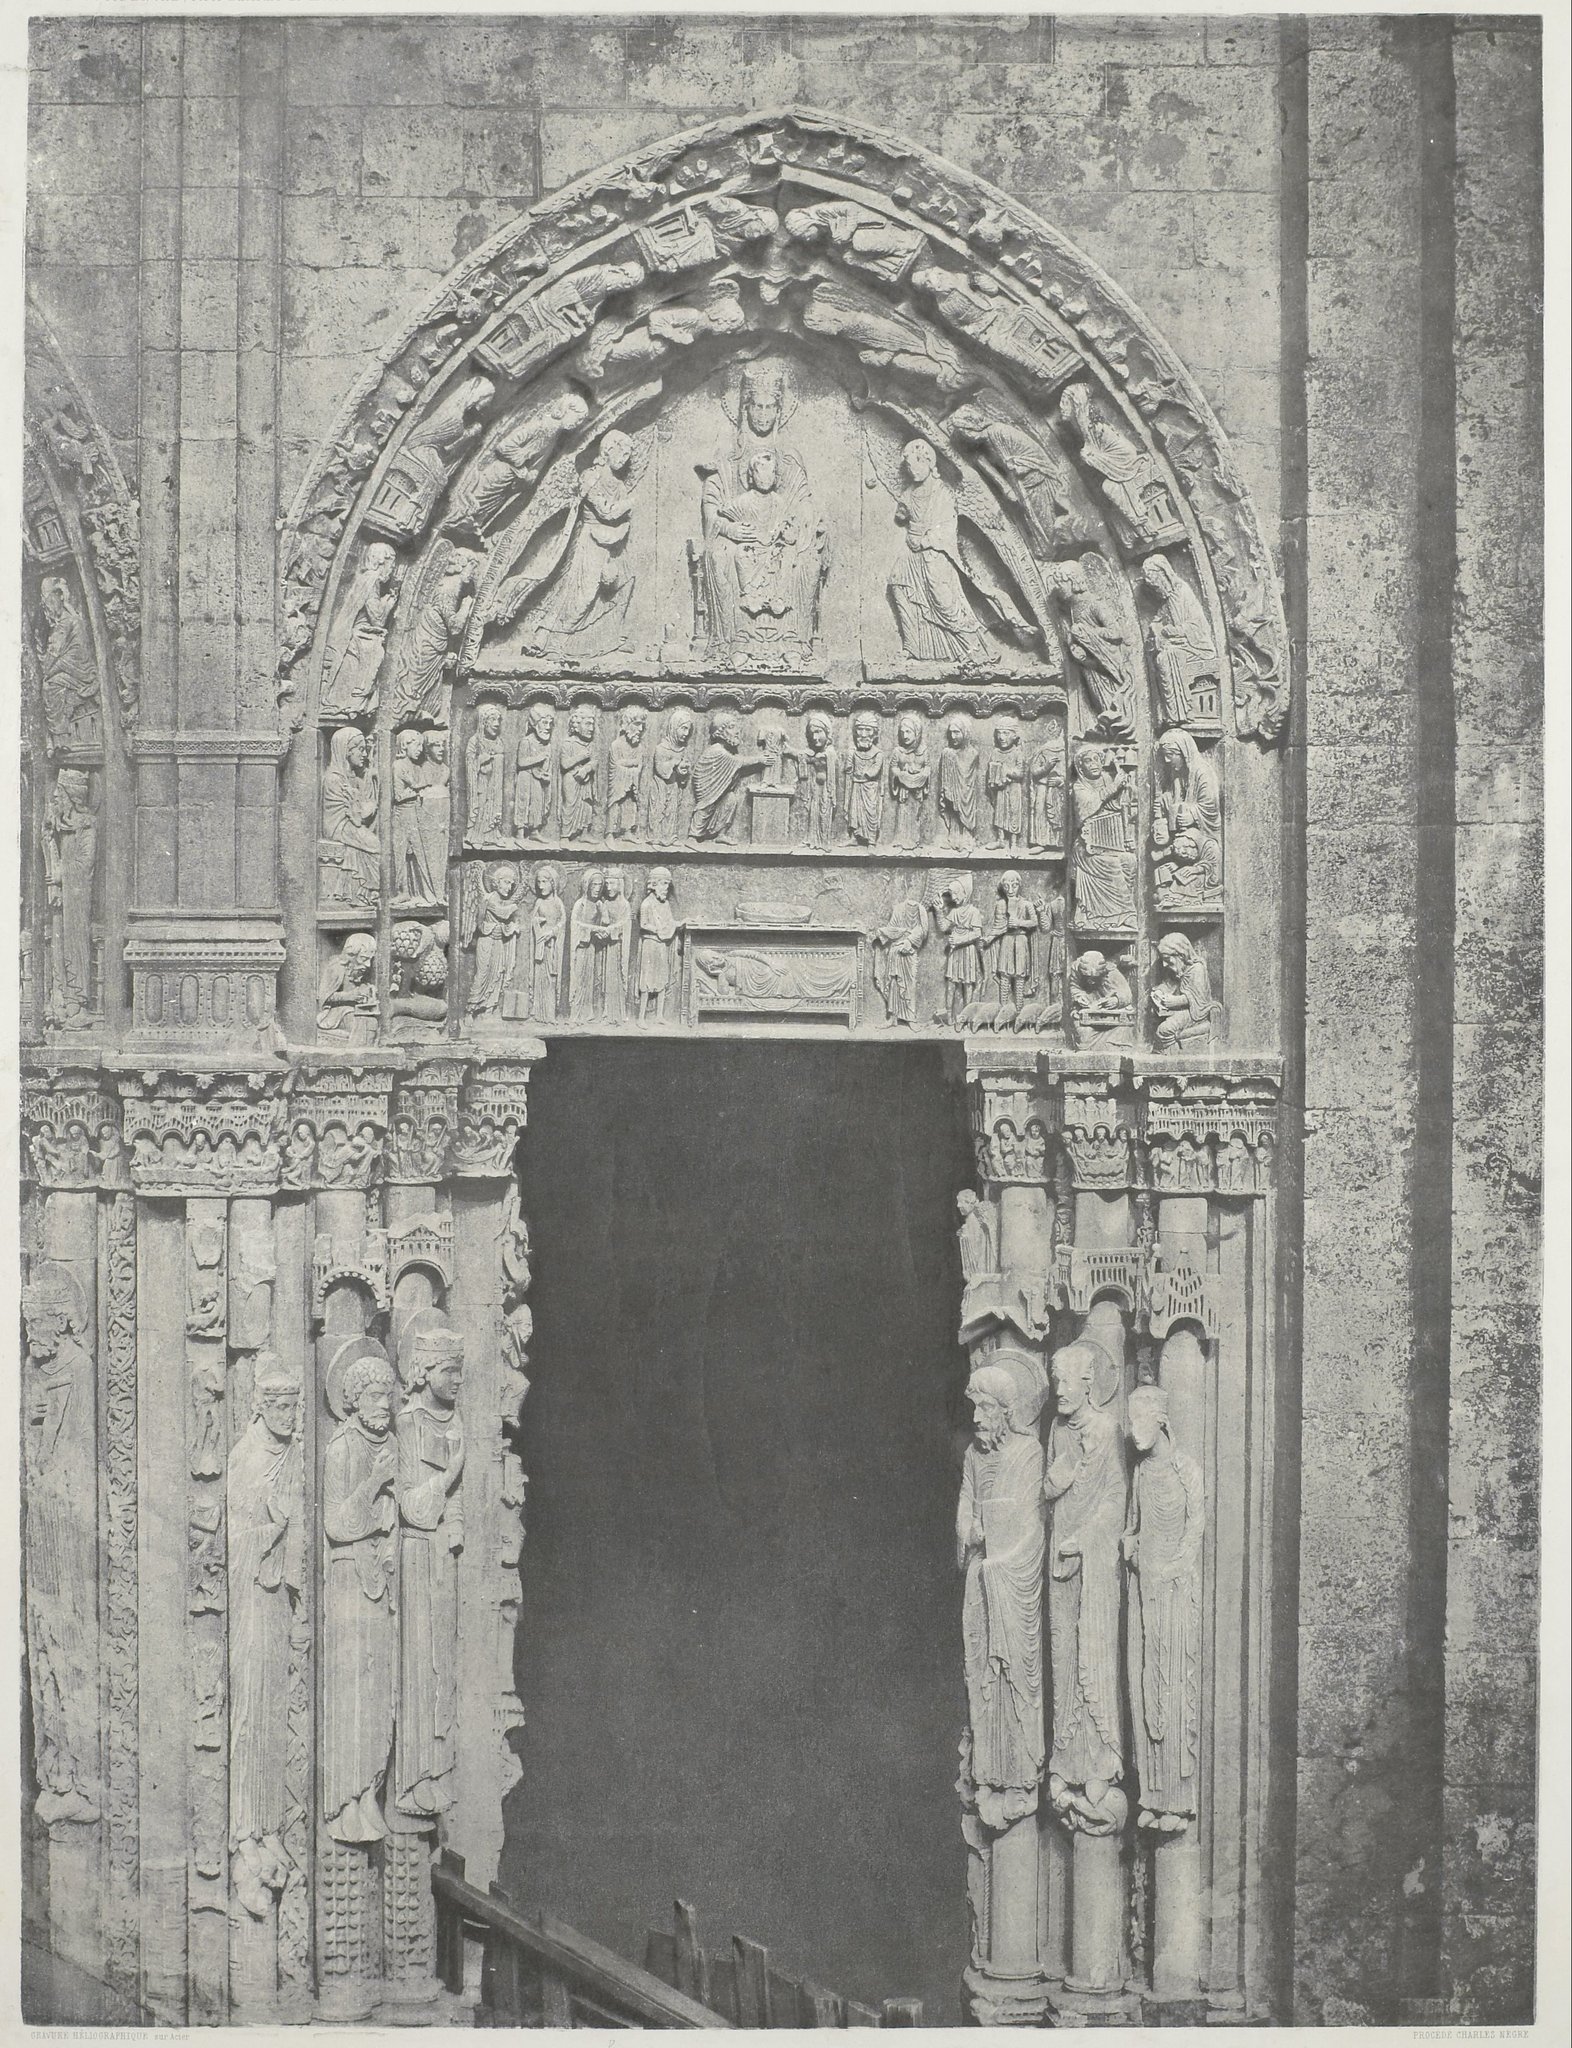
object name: photomechanical print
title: Côté Occidental, Porte Latérale de droite XII Siècle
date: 1854-1857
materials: cardboard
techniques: photoaquatint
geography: chartres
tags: parts of church exterior and annexes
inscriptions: inscription: ‘GRAVURE HÉLIOGRAPHIQUE sur Acier’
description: Plaat VII uit Monographie de la Cathédrale de Chartres.